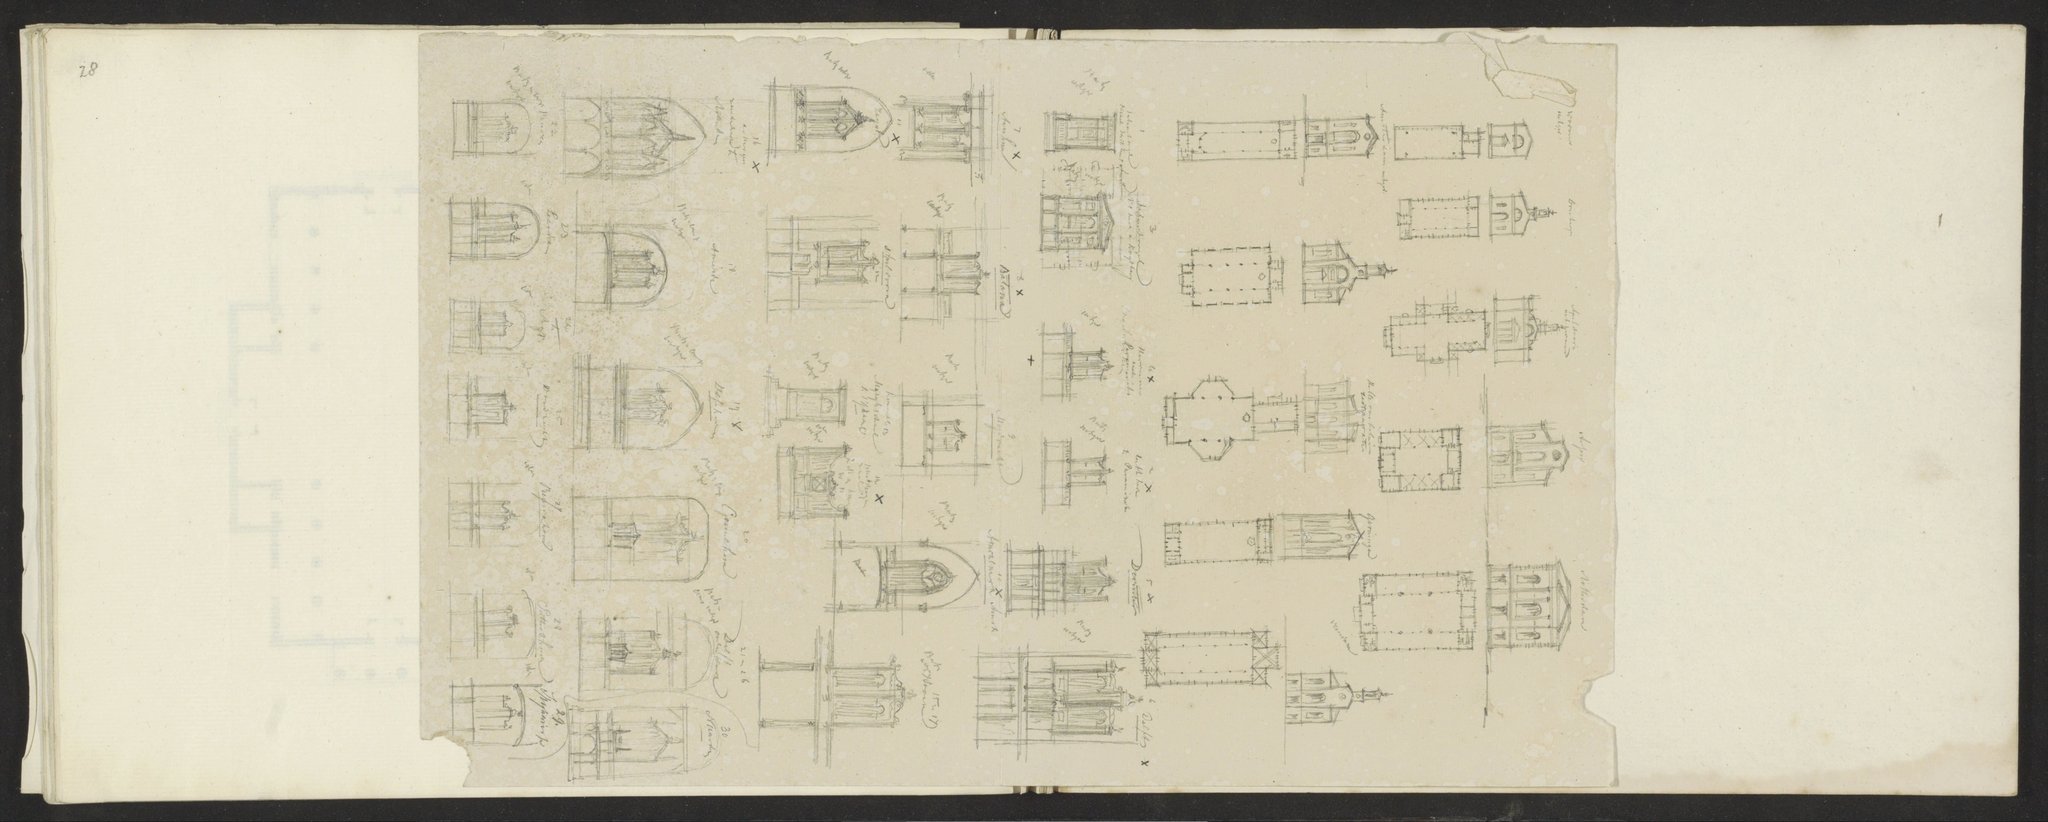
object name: sketchbook leaf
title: Studieblad met plattegronden, voorgevels en architectuurdetails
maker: willem springer jr.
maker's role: draughtsman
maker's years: 1815-1907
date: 1825-1907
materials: paper, pencil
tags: architectural detail, façade (of house or building), plan ~ architecture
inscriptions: annotation: ‘Wormer/ Driebergen/ Apeldoorn/ Assen/ Rotterdam/ ...’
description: Studies van (details van) gebouwen in Nederland. Recto van een los blad tussen pagina 28 en de binnenzijde van de omslag van een schetsboek met 28 pagina's.